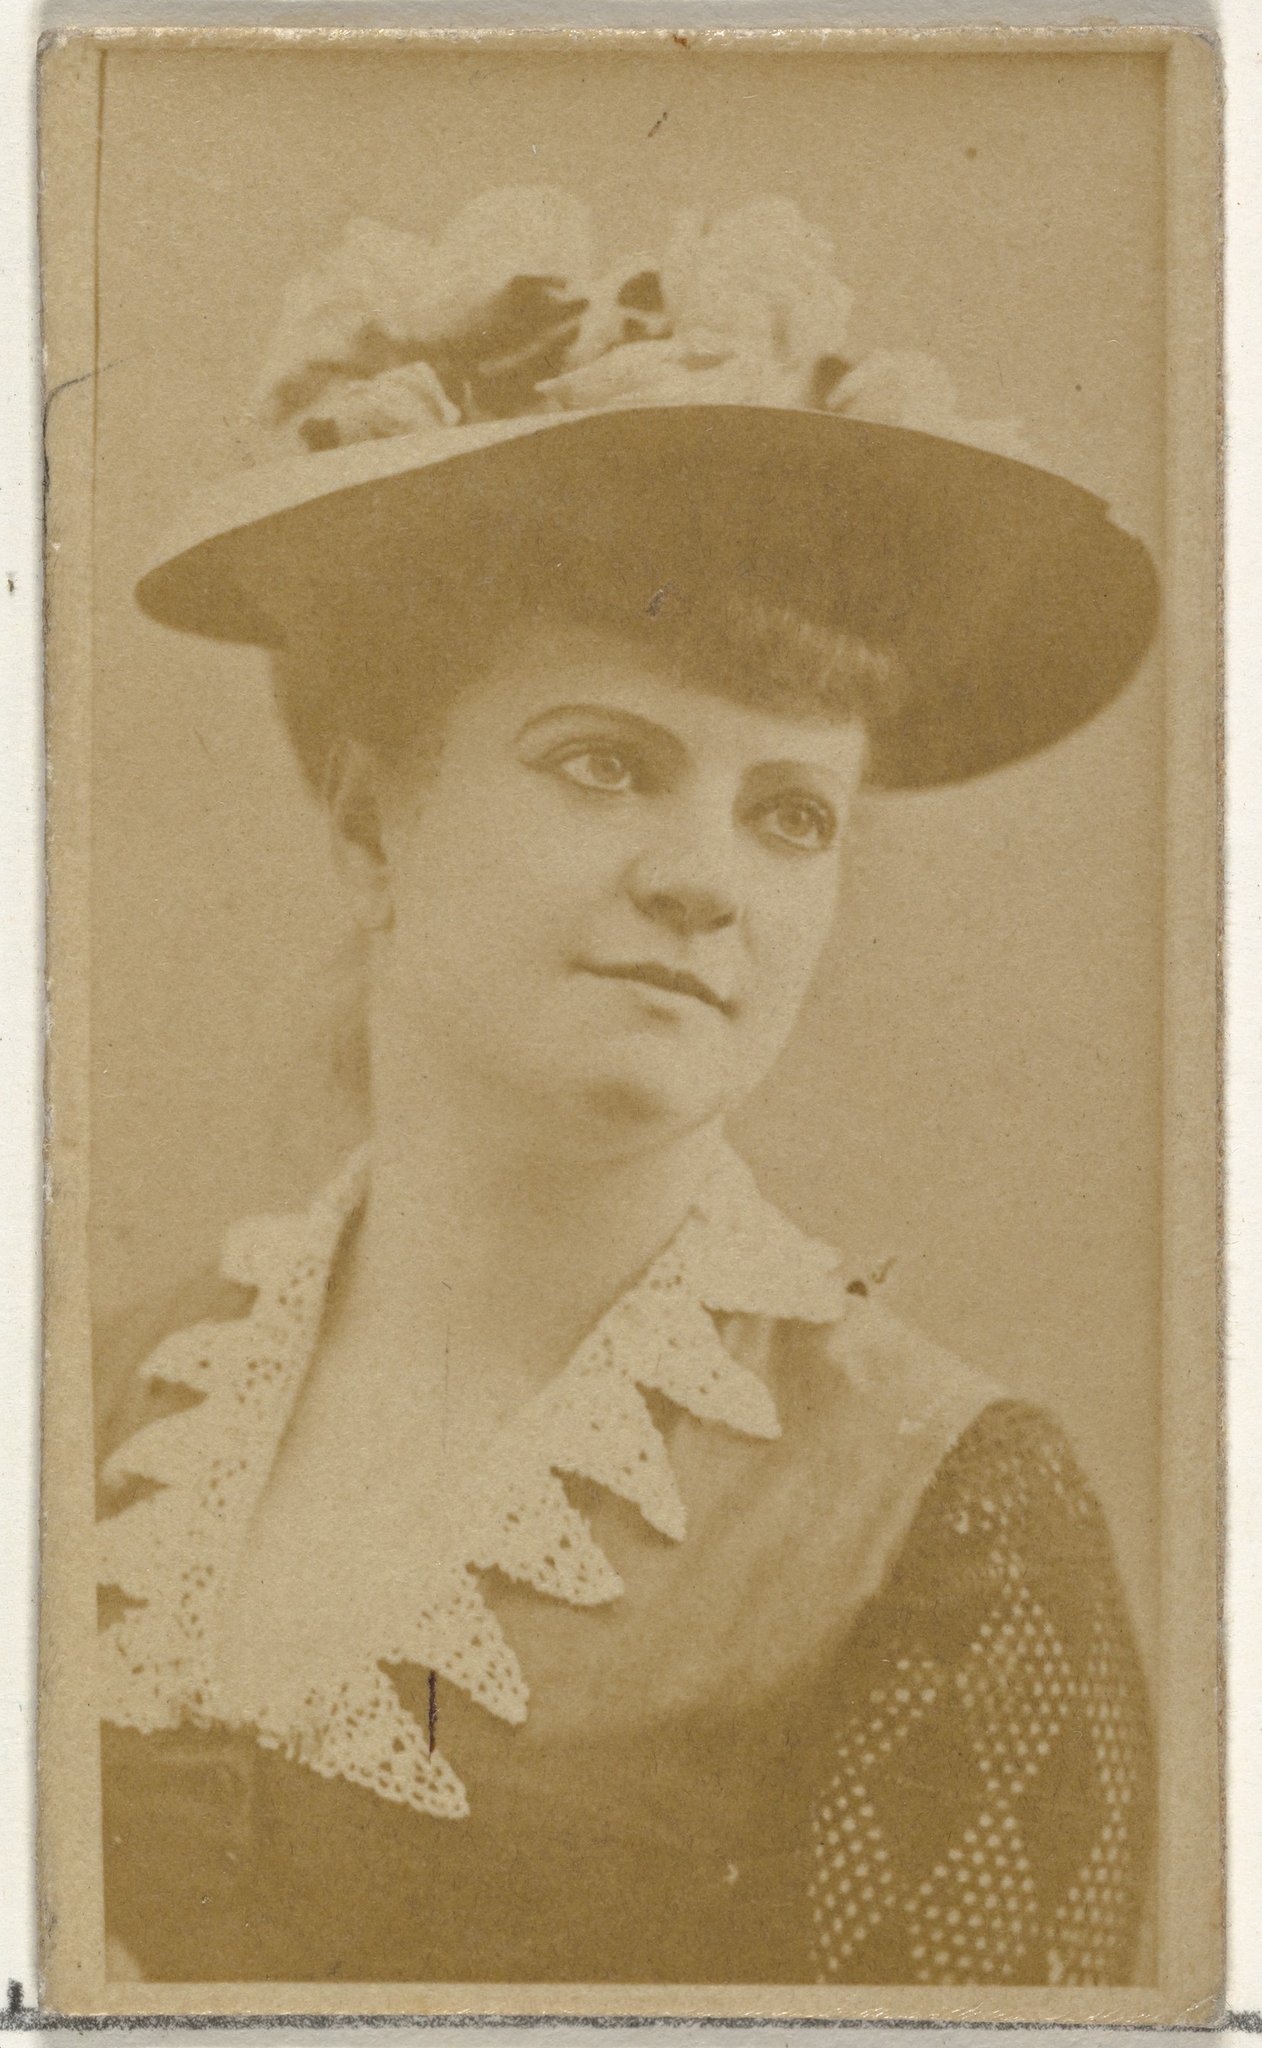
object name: photograph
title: [Actress wearing dress with ornate lace collar], from the Actors and Actresses series (N145-8) issued by Duke Sons & Co. to promote Duke Cigarettes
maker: w. duke, sons & co.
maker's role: publisher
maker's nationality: american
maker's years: 1870-1920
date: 1891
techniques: albumen silver print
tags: portraits,women,actresses